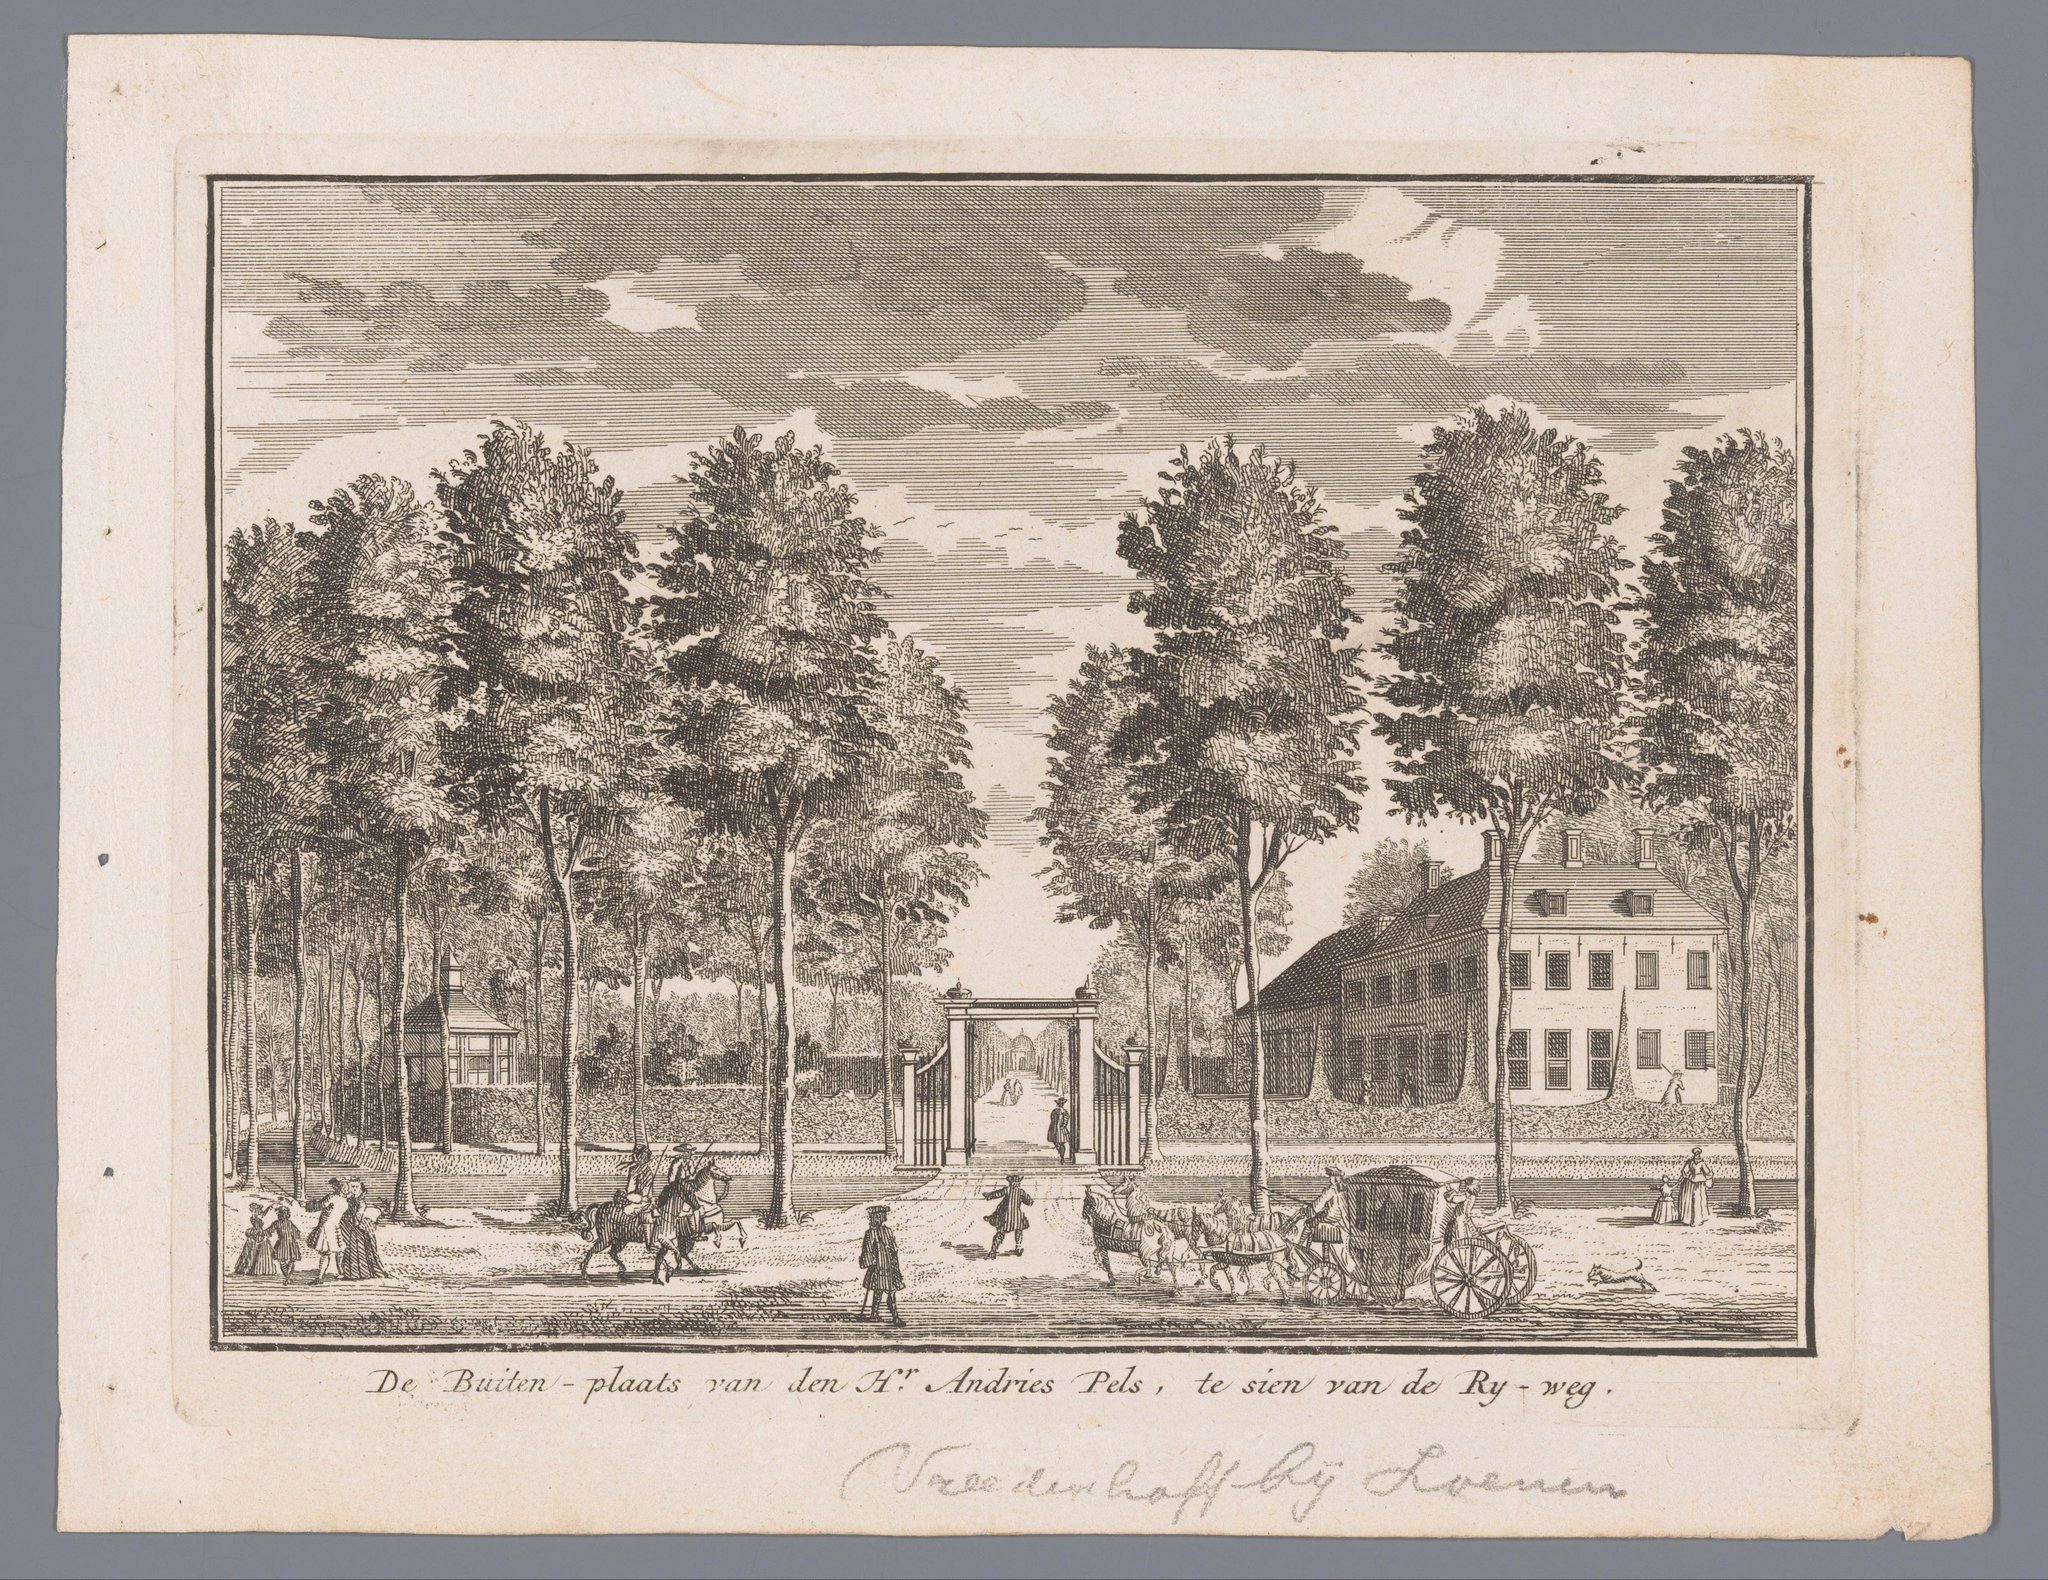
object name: print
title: De Buiten-plaats van den Hr. Andries Pels, te sien van de Ry-weg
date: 1718-1757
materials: paper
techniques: etching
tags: amsterdam, rural housing, e.g. country-house, villa, cottage, lane, alley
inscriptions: collector's mark: Lugt 2228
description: Behoort tot een reeks van elf afbeeldingen met buitenplaatsen. Kopie naar prent in: Stopendaal, Daniel. De zegepraalende Vecht, vertoonende verscheidenen gesichten van lustplaatsen, heeren huysen en dorpen, beginnende van Uitrecht en met Muyden besluytende. Amsterdam: Weduwe Nicolaas Visscher, 1719.